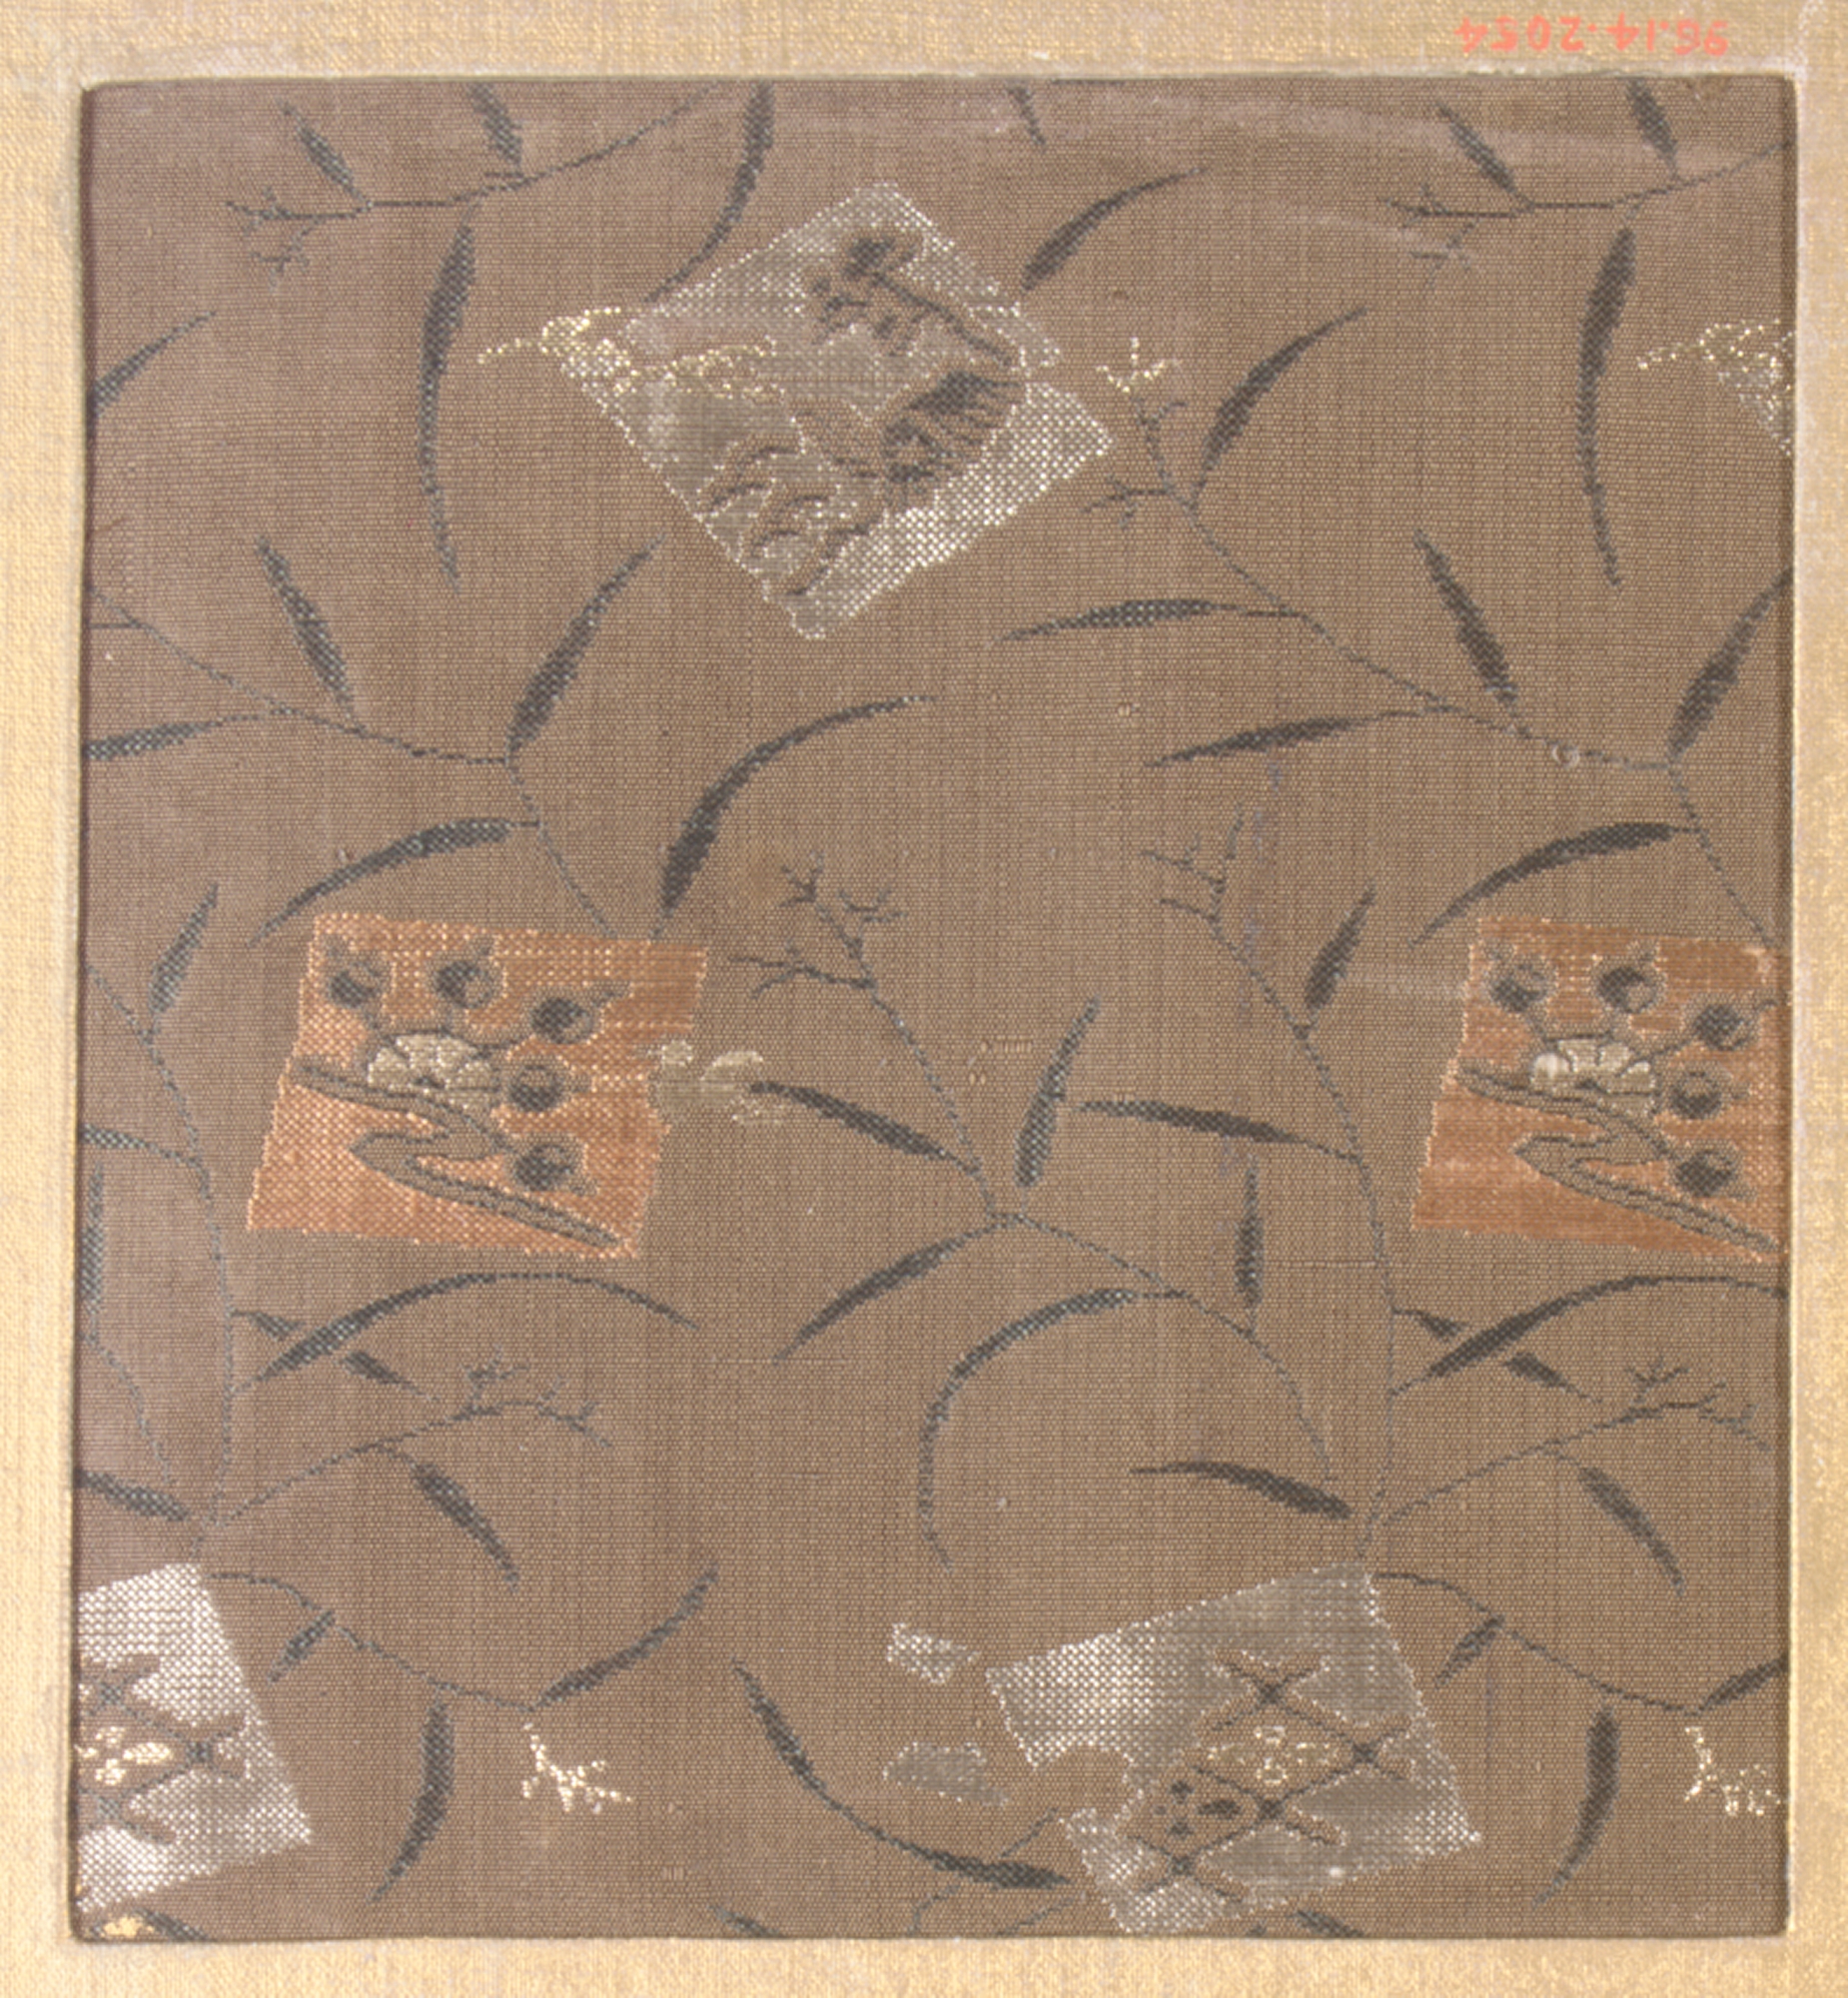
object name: piece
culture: japanese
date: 1701-1900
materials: silk